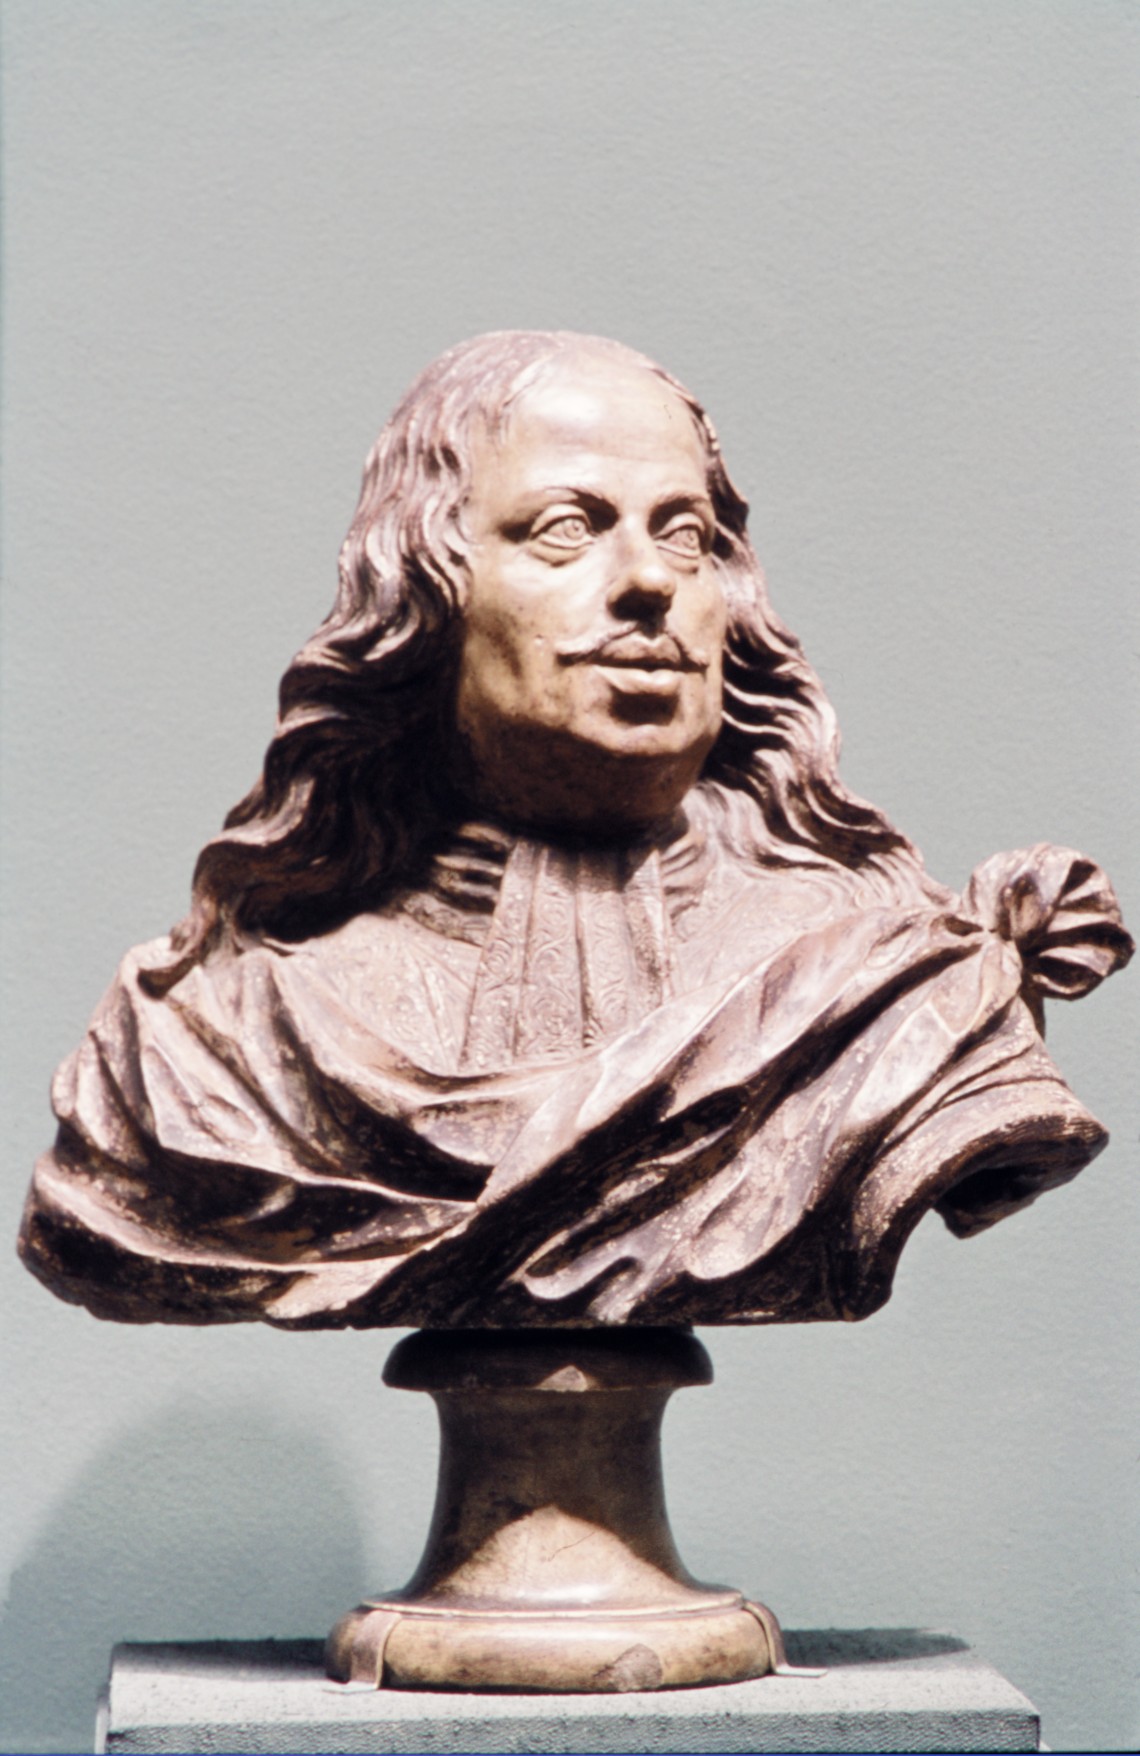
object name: bust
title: Cosimo III de' Medici, b. 1642, Grand Duke of Tuscany 1670–1723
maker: giovanni battista foggini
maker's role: artist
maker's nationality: italian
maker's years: 1652-1725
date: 1676-1684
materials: terracotta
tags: men,portraits